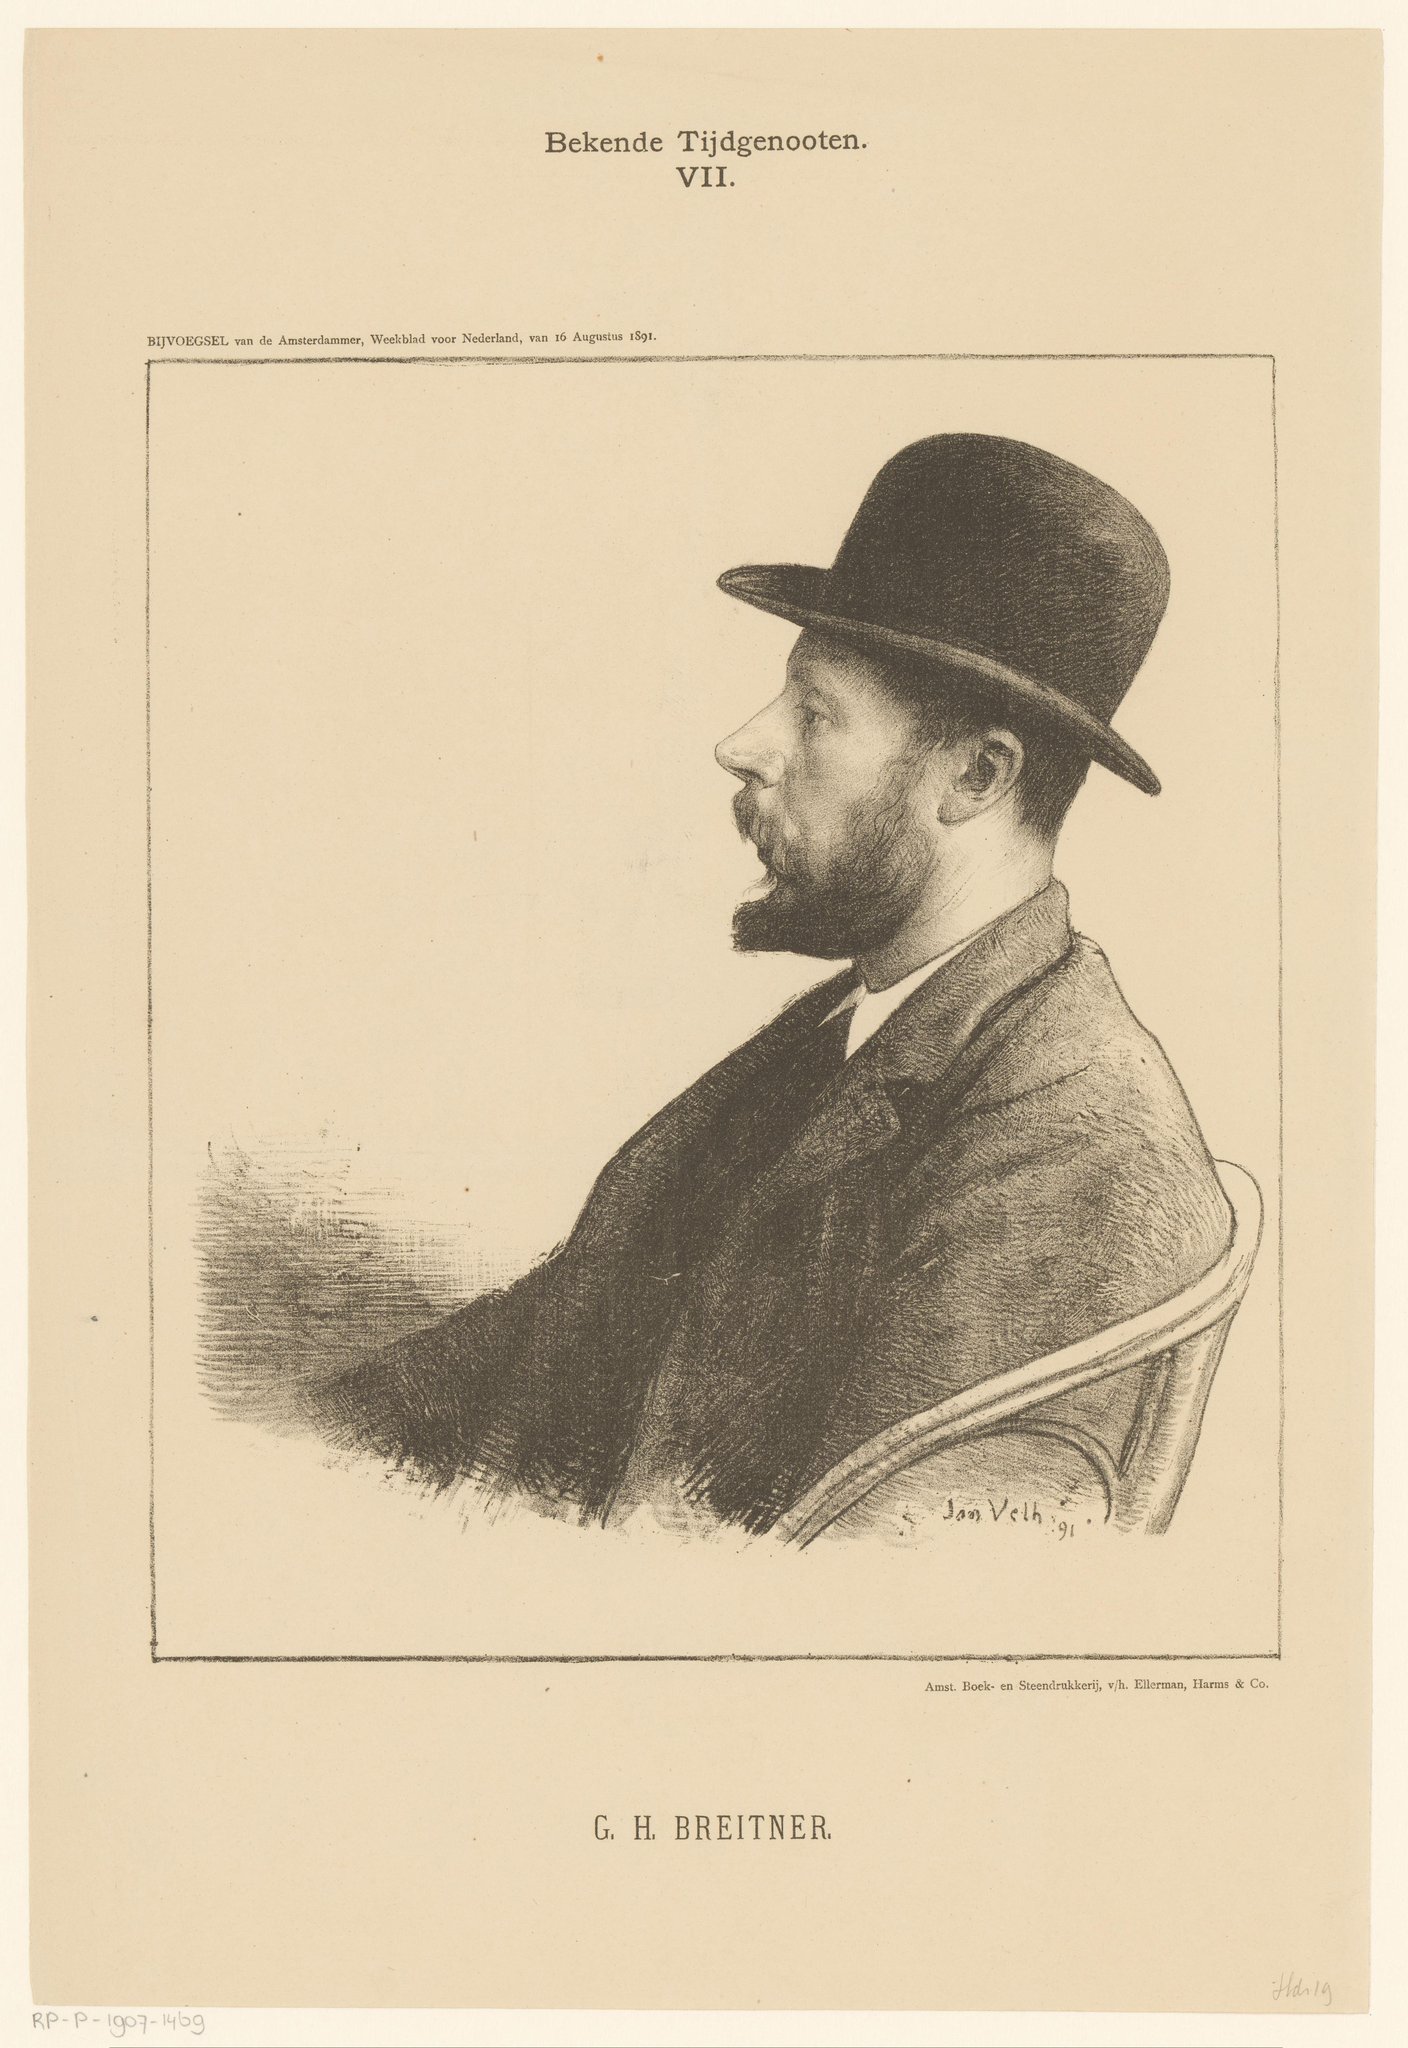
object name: print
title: Portret van George Hendrik Breitner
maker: jan veth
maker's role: designer, draughtsman, painter, print maker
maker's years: 1864-1925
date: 1891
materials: paper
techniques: lithograph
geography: amsterdam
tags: rotterdam, amsterdam, painter, draughtsman, george hendrik breitner, historical persons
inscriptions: collector's mark: Lugt 2228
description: Deze prent werd uitgegeven als bijvoegsel van De Amsterdammer op 116 augustus 1891.